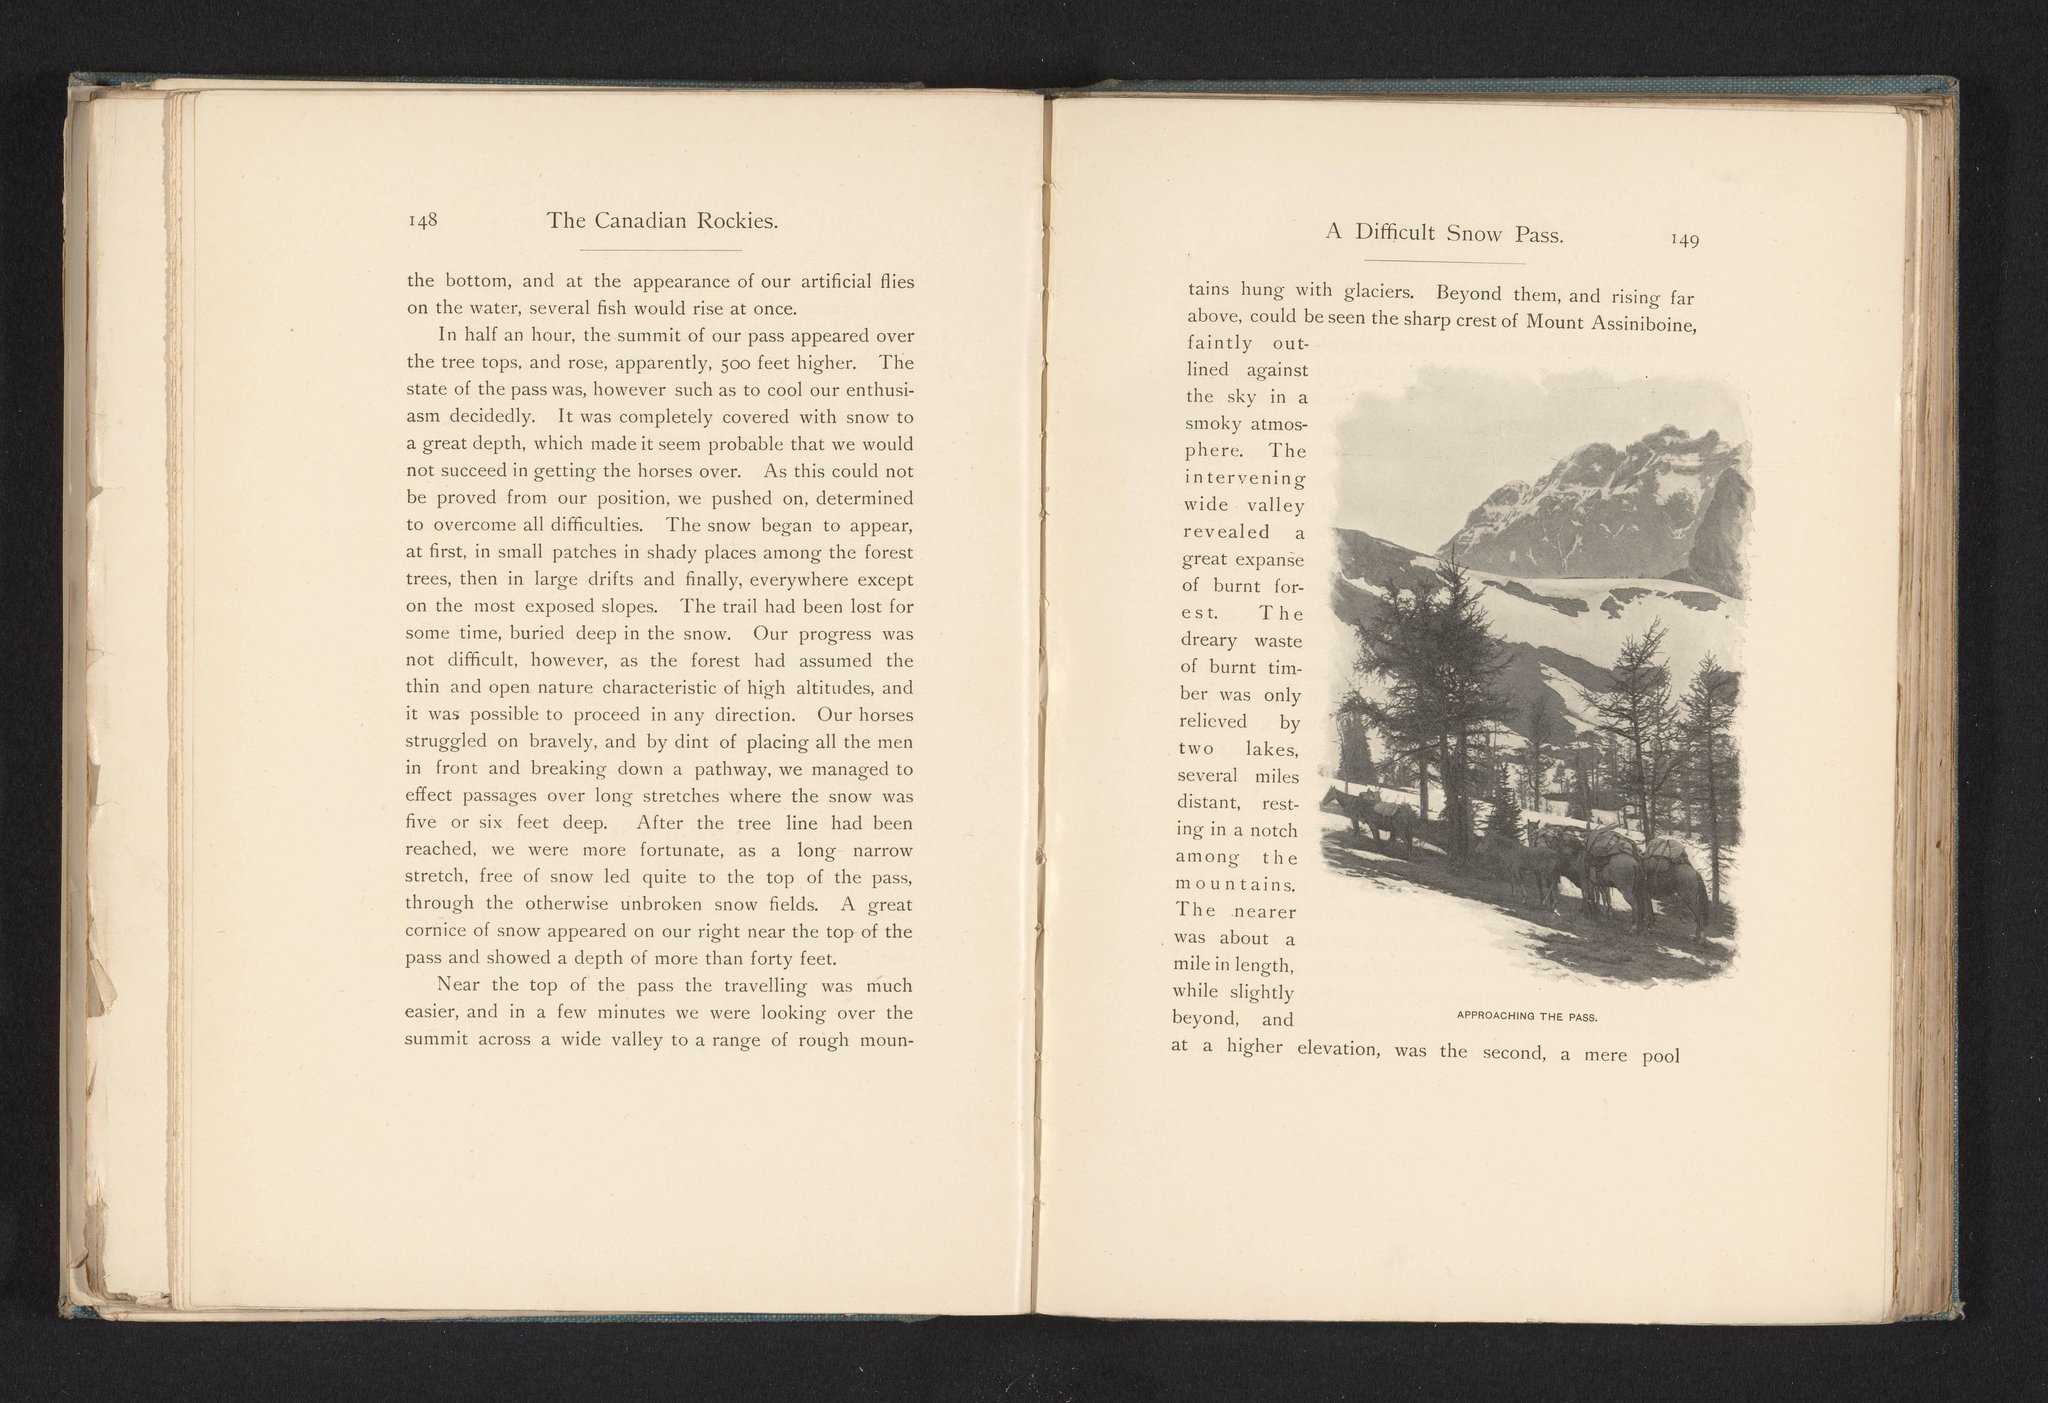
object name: photomechanical print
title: Paarden voor een dal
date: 1893-1897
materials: paper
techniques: autotype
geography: canada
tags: dale, valley, horse